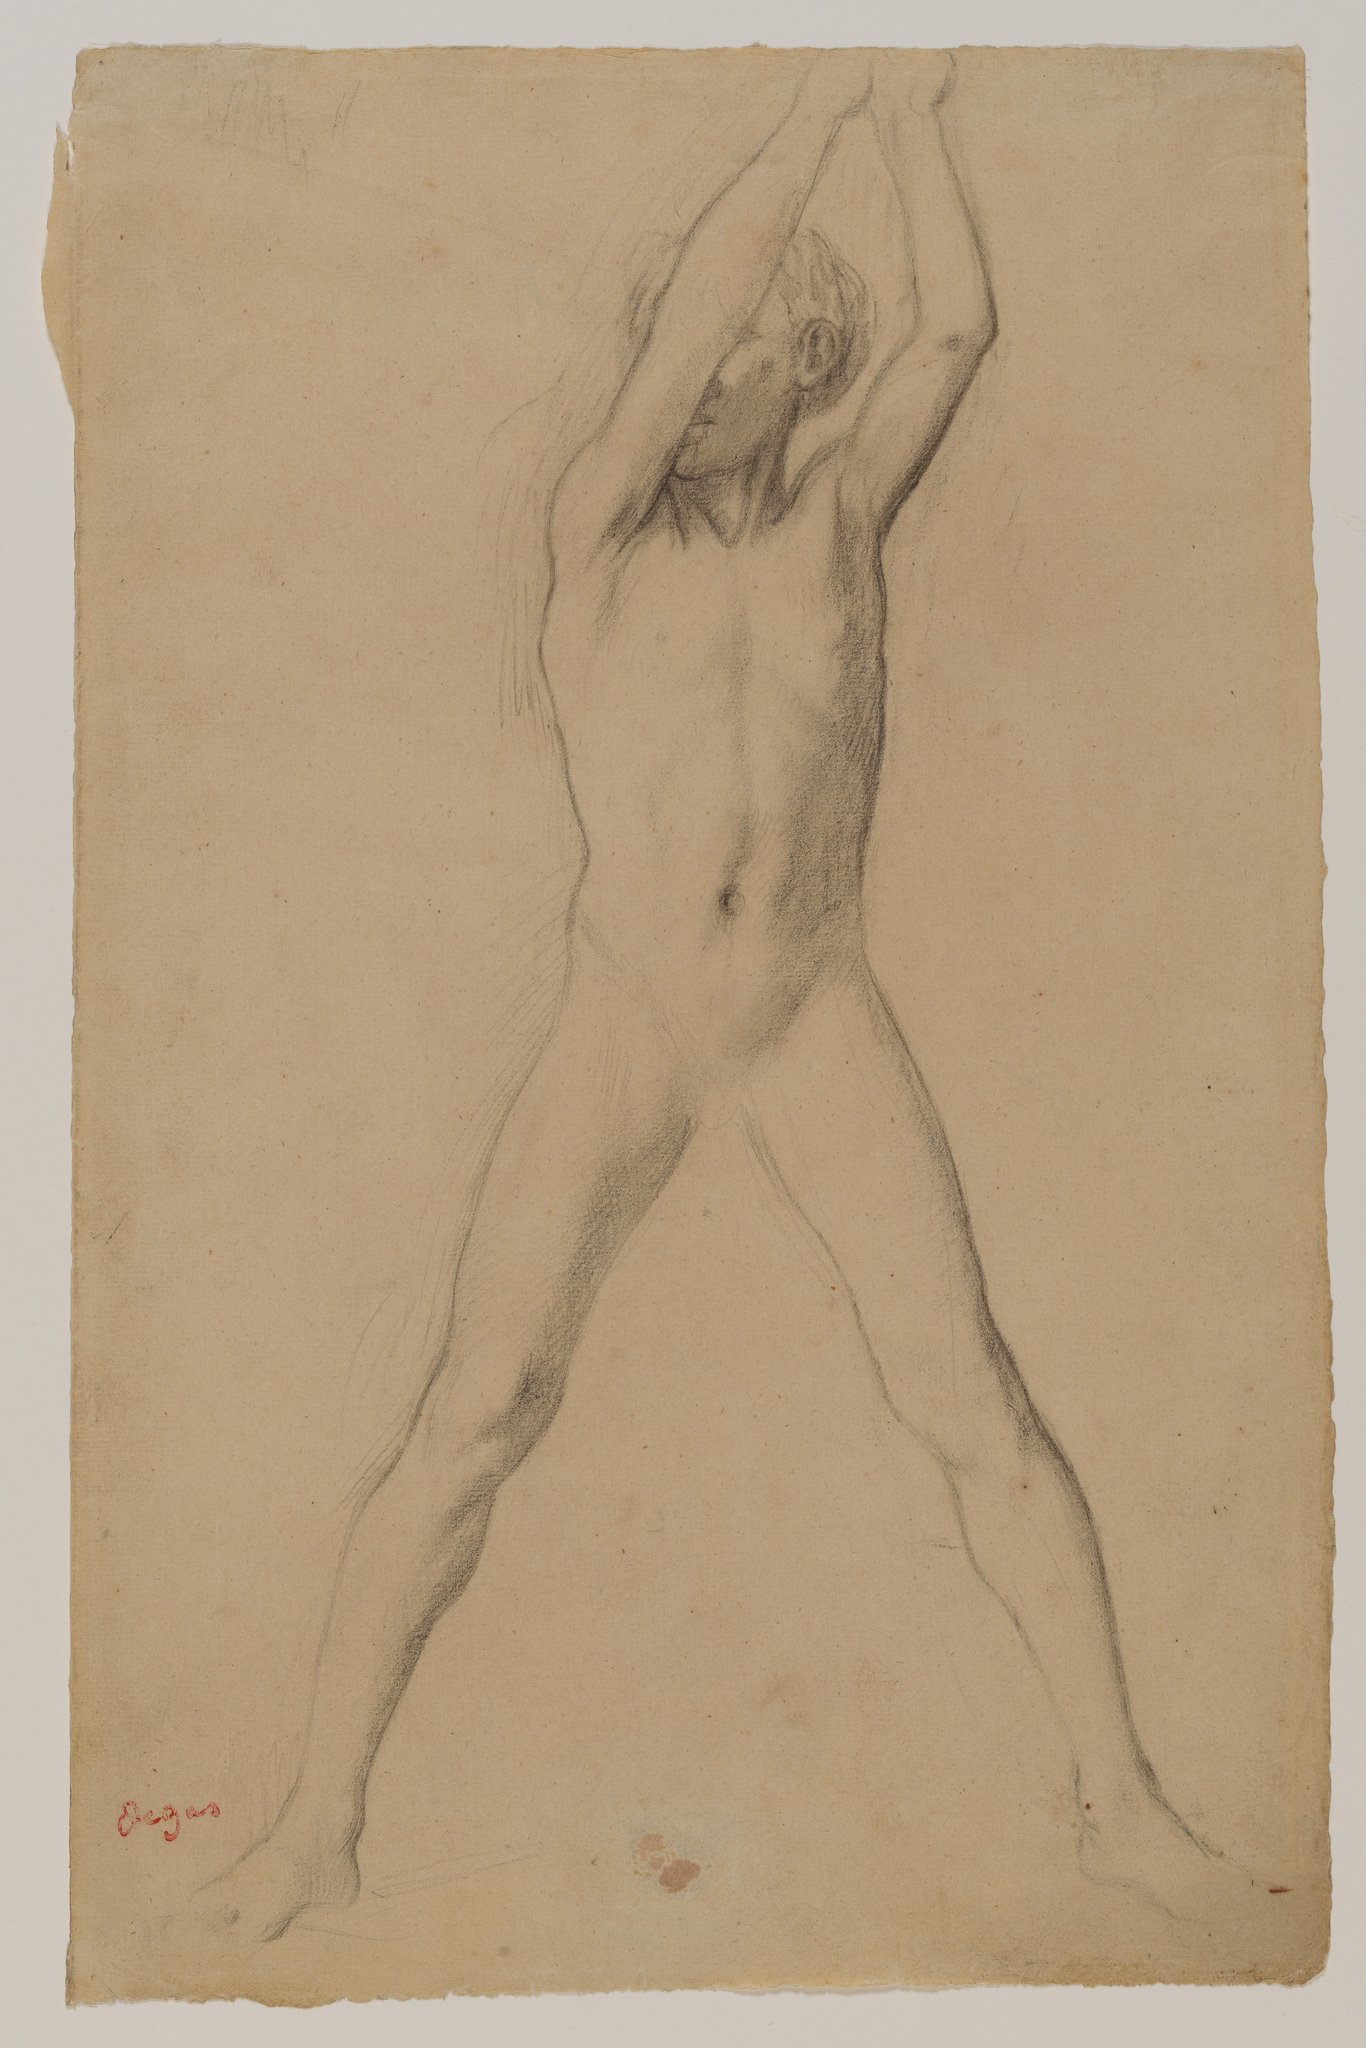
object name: drawing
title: Youth with Arms Upraised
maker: edgar degas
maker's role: artist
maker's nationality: french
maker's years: 1834-1917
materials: chalk, paper, pencil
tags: male nudes